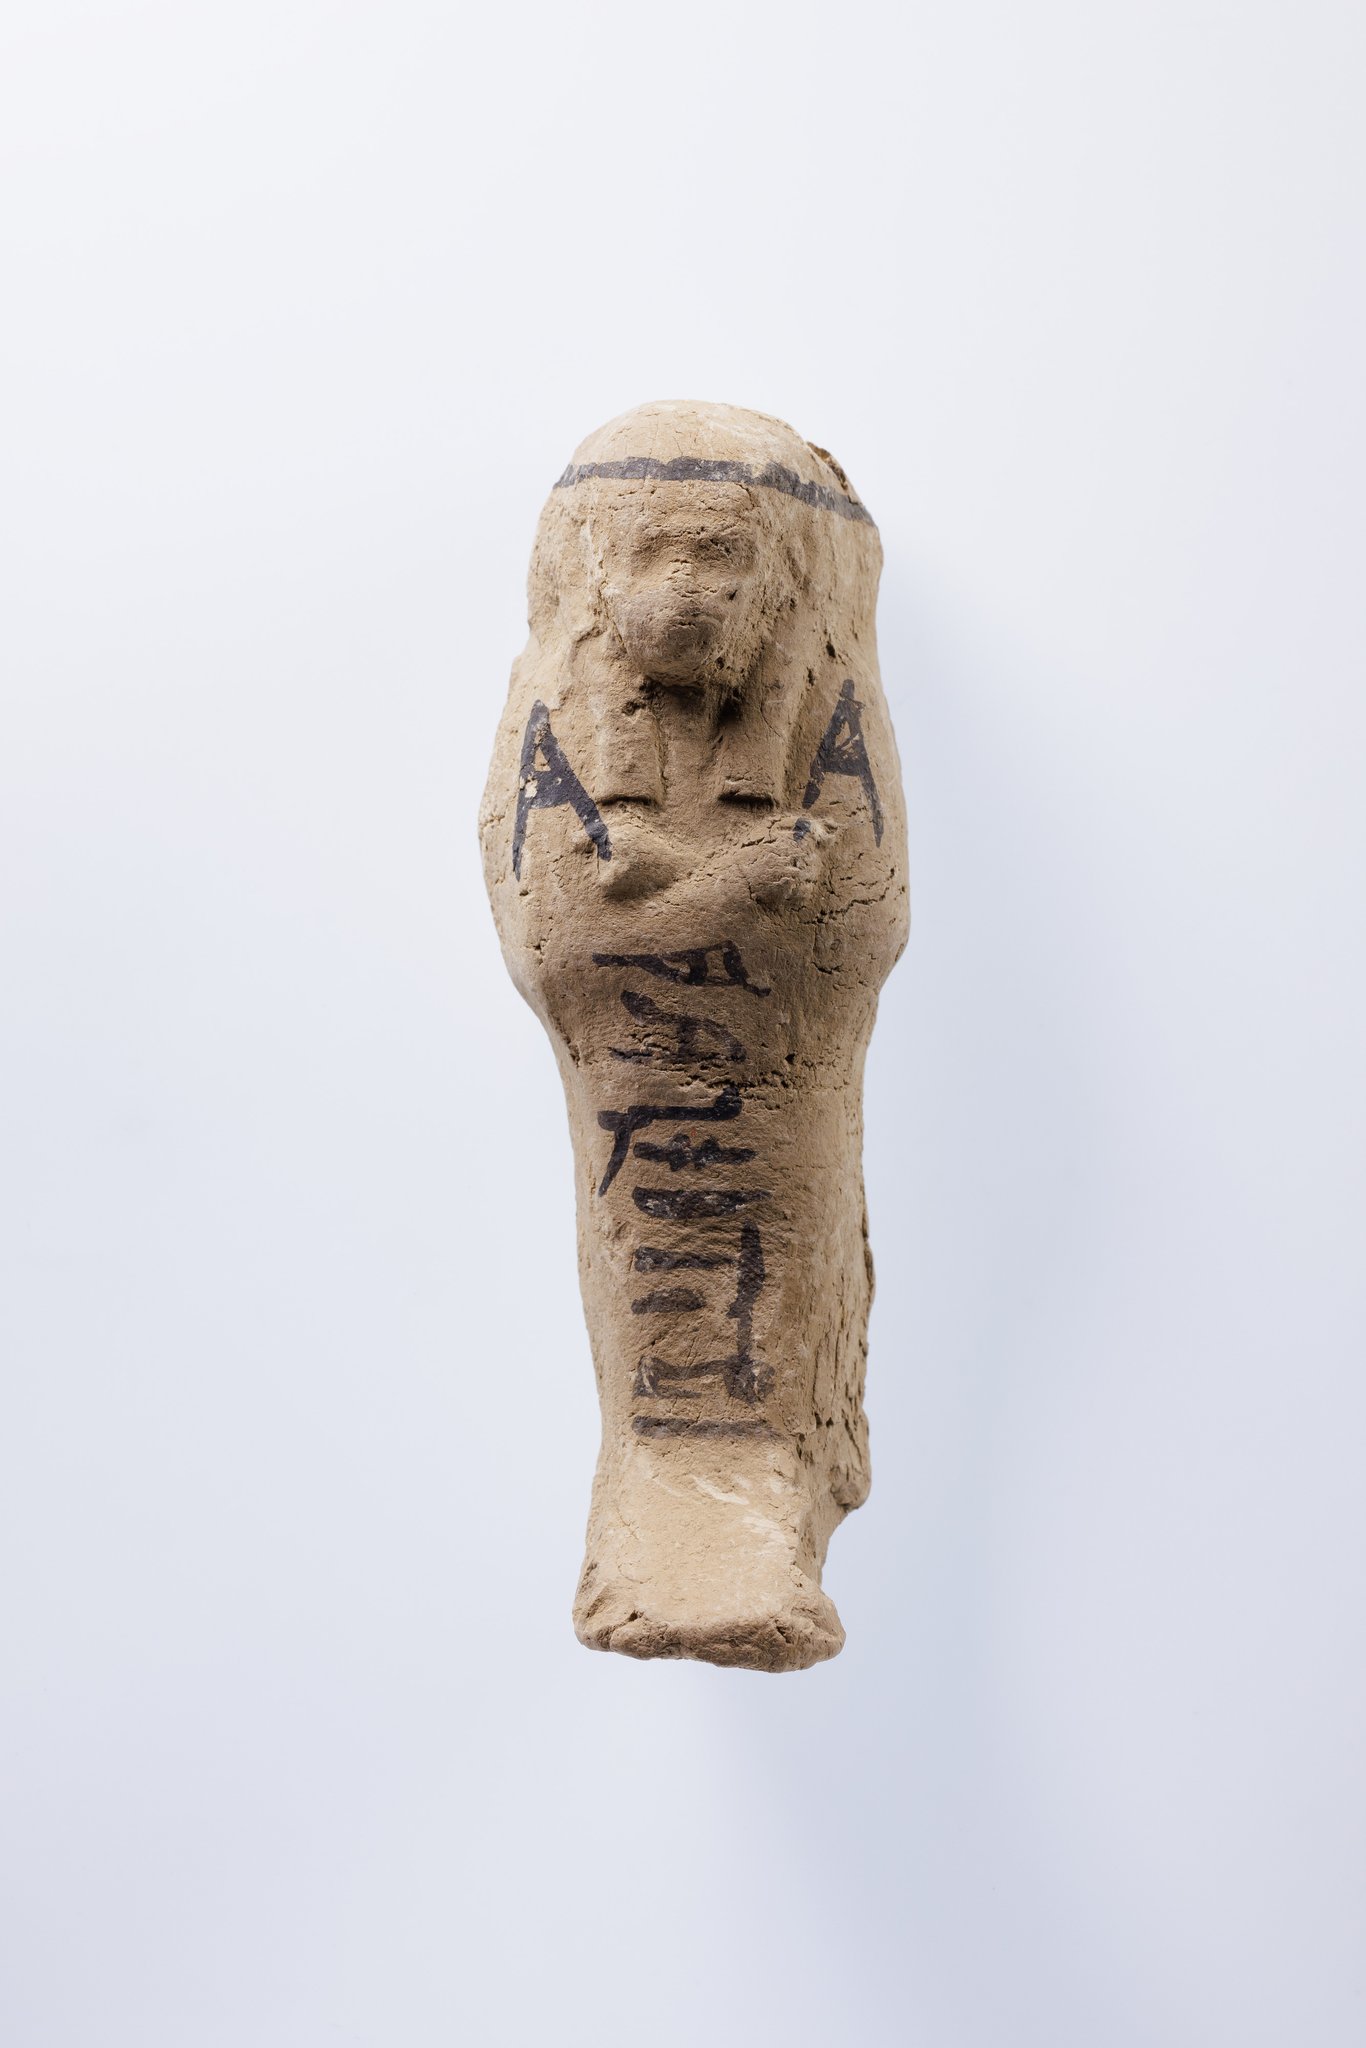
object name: shabti, nesinebtasheru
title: Shabti of Nesinebtasheru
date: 1070-945 BCE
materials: clay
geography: egypt